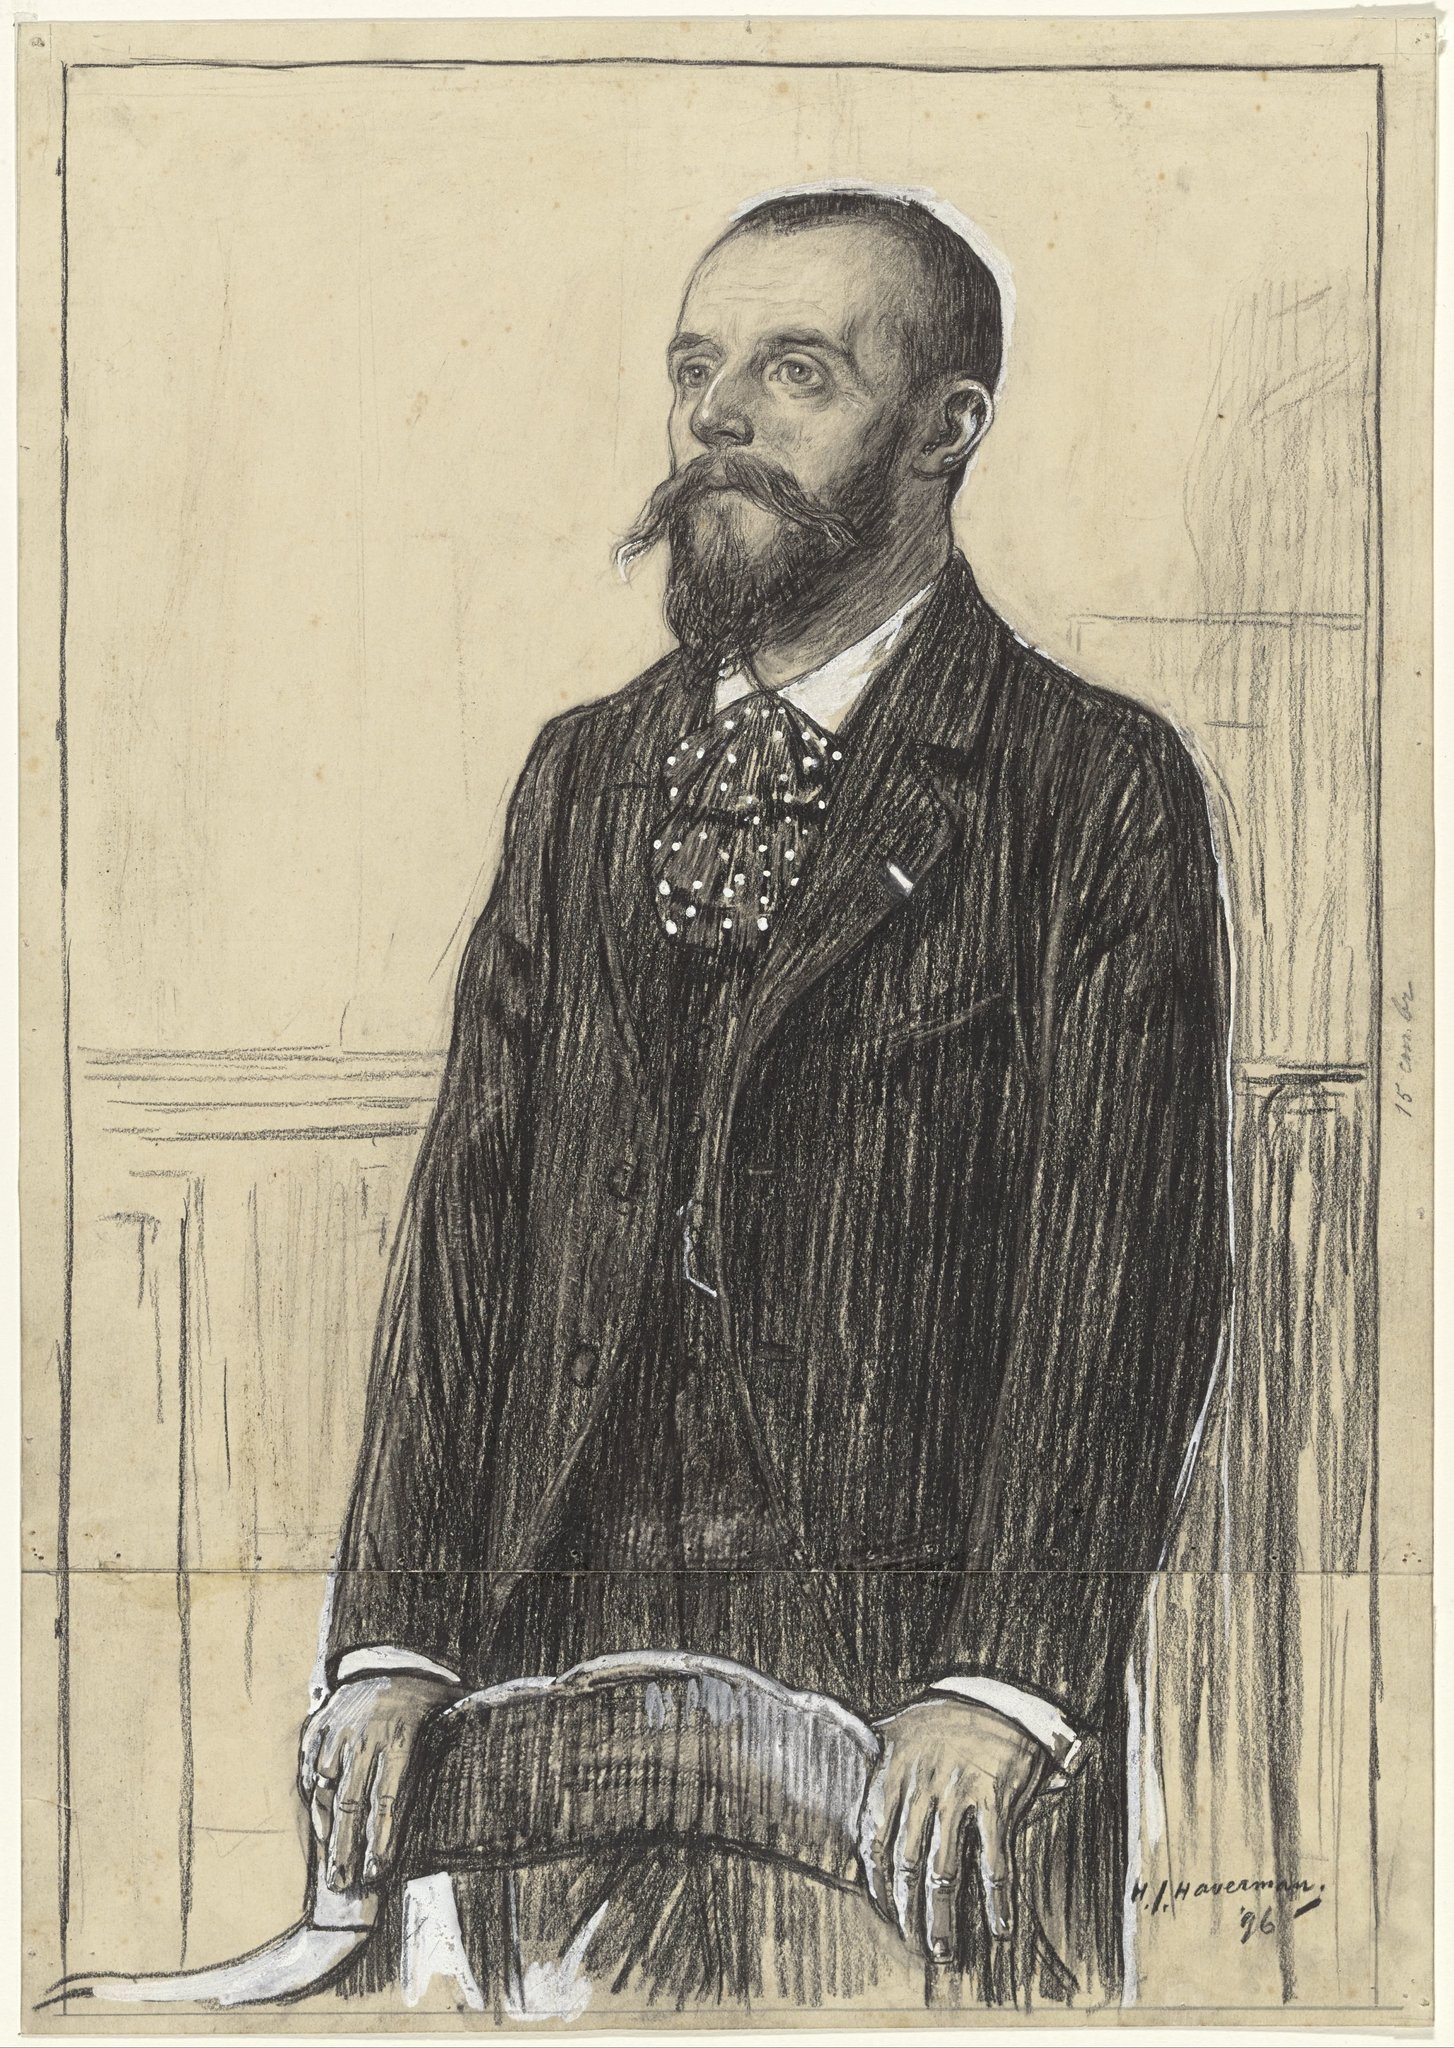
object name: drawing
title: Portret van prof. Hector Treub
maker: hendrik johannes haverman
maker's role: draughtsman, print maker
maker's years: 1857-1928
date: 1896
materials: chalk, paint, paper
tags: utrecht, historical persons